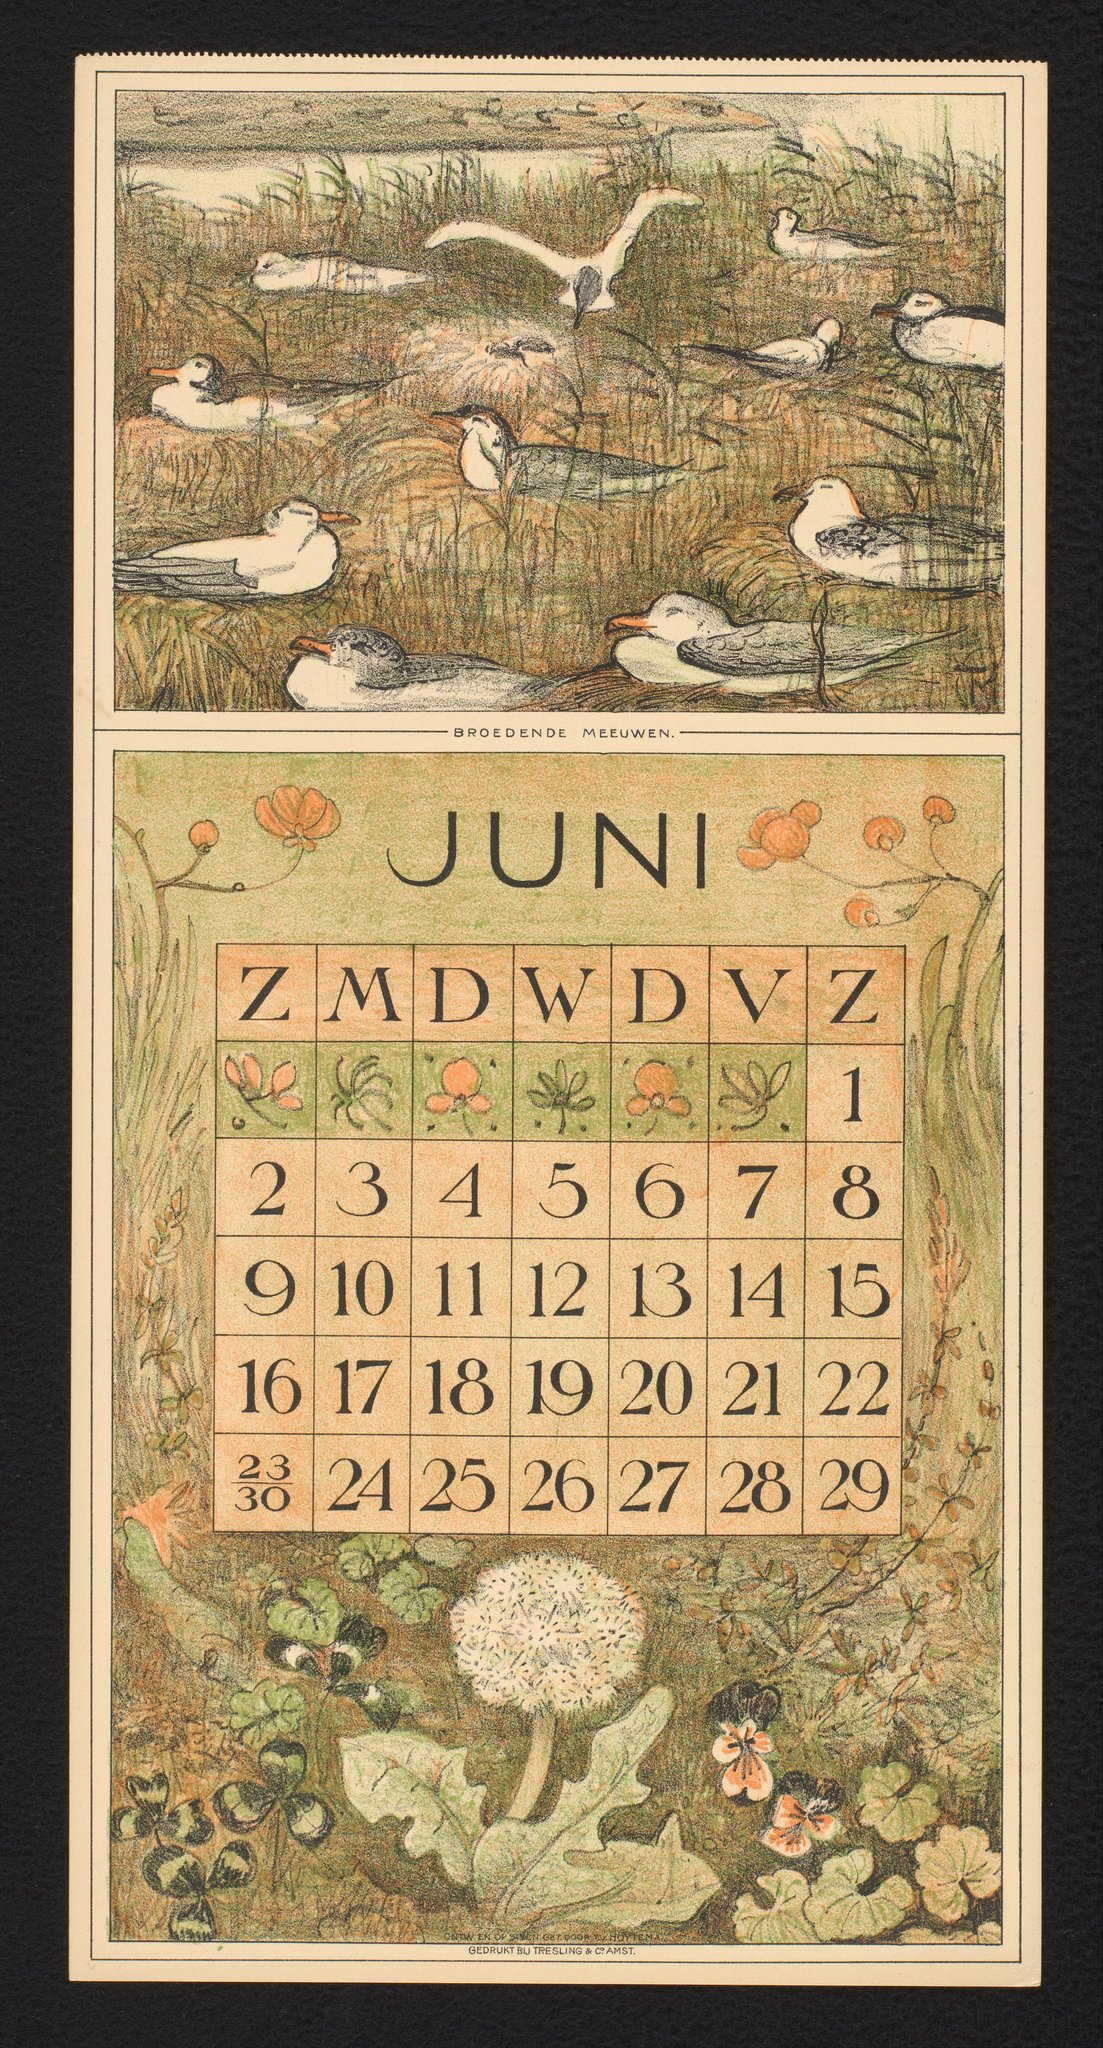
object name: calendar leaf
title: Broedende meeuwen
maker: theo van hoytema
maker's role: draughtsman, painter, print maker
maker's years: 1863-1917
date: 1911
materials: paper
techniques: lithograph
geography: amsterdam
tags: shore-birds and wading-birds: gull